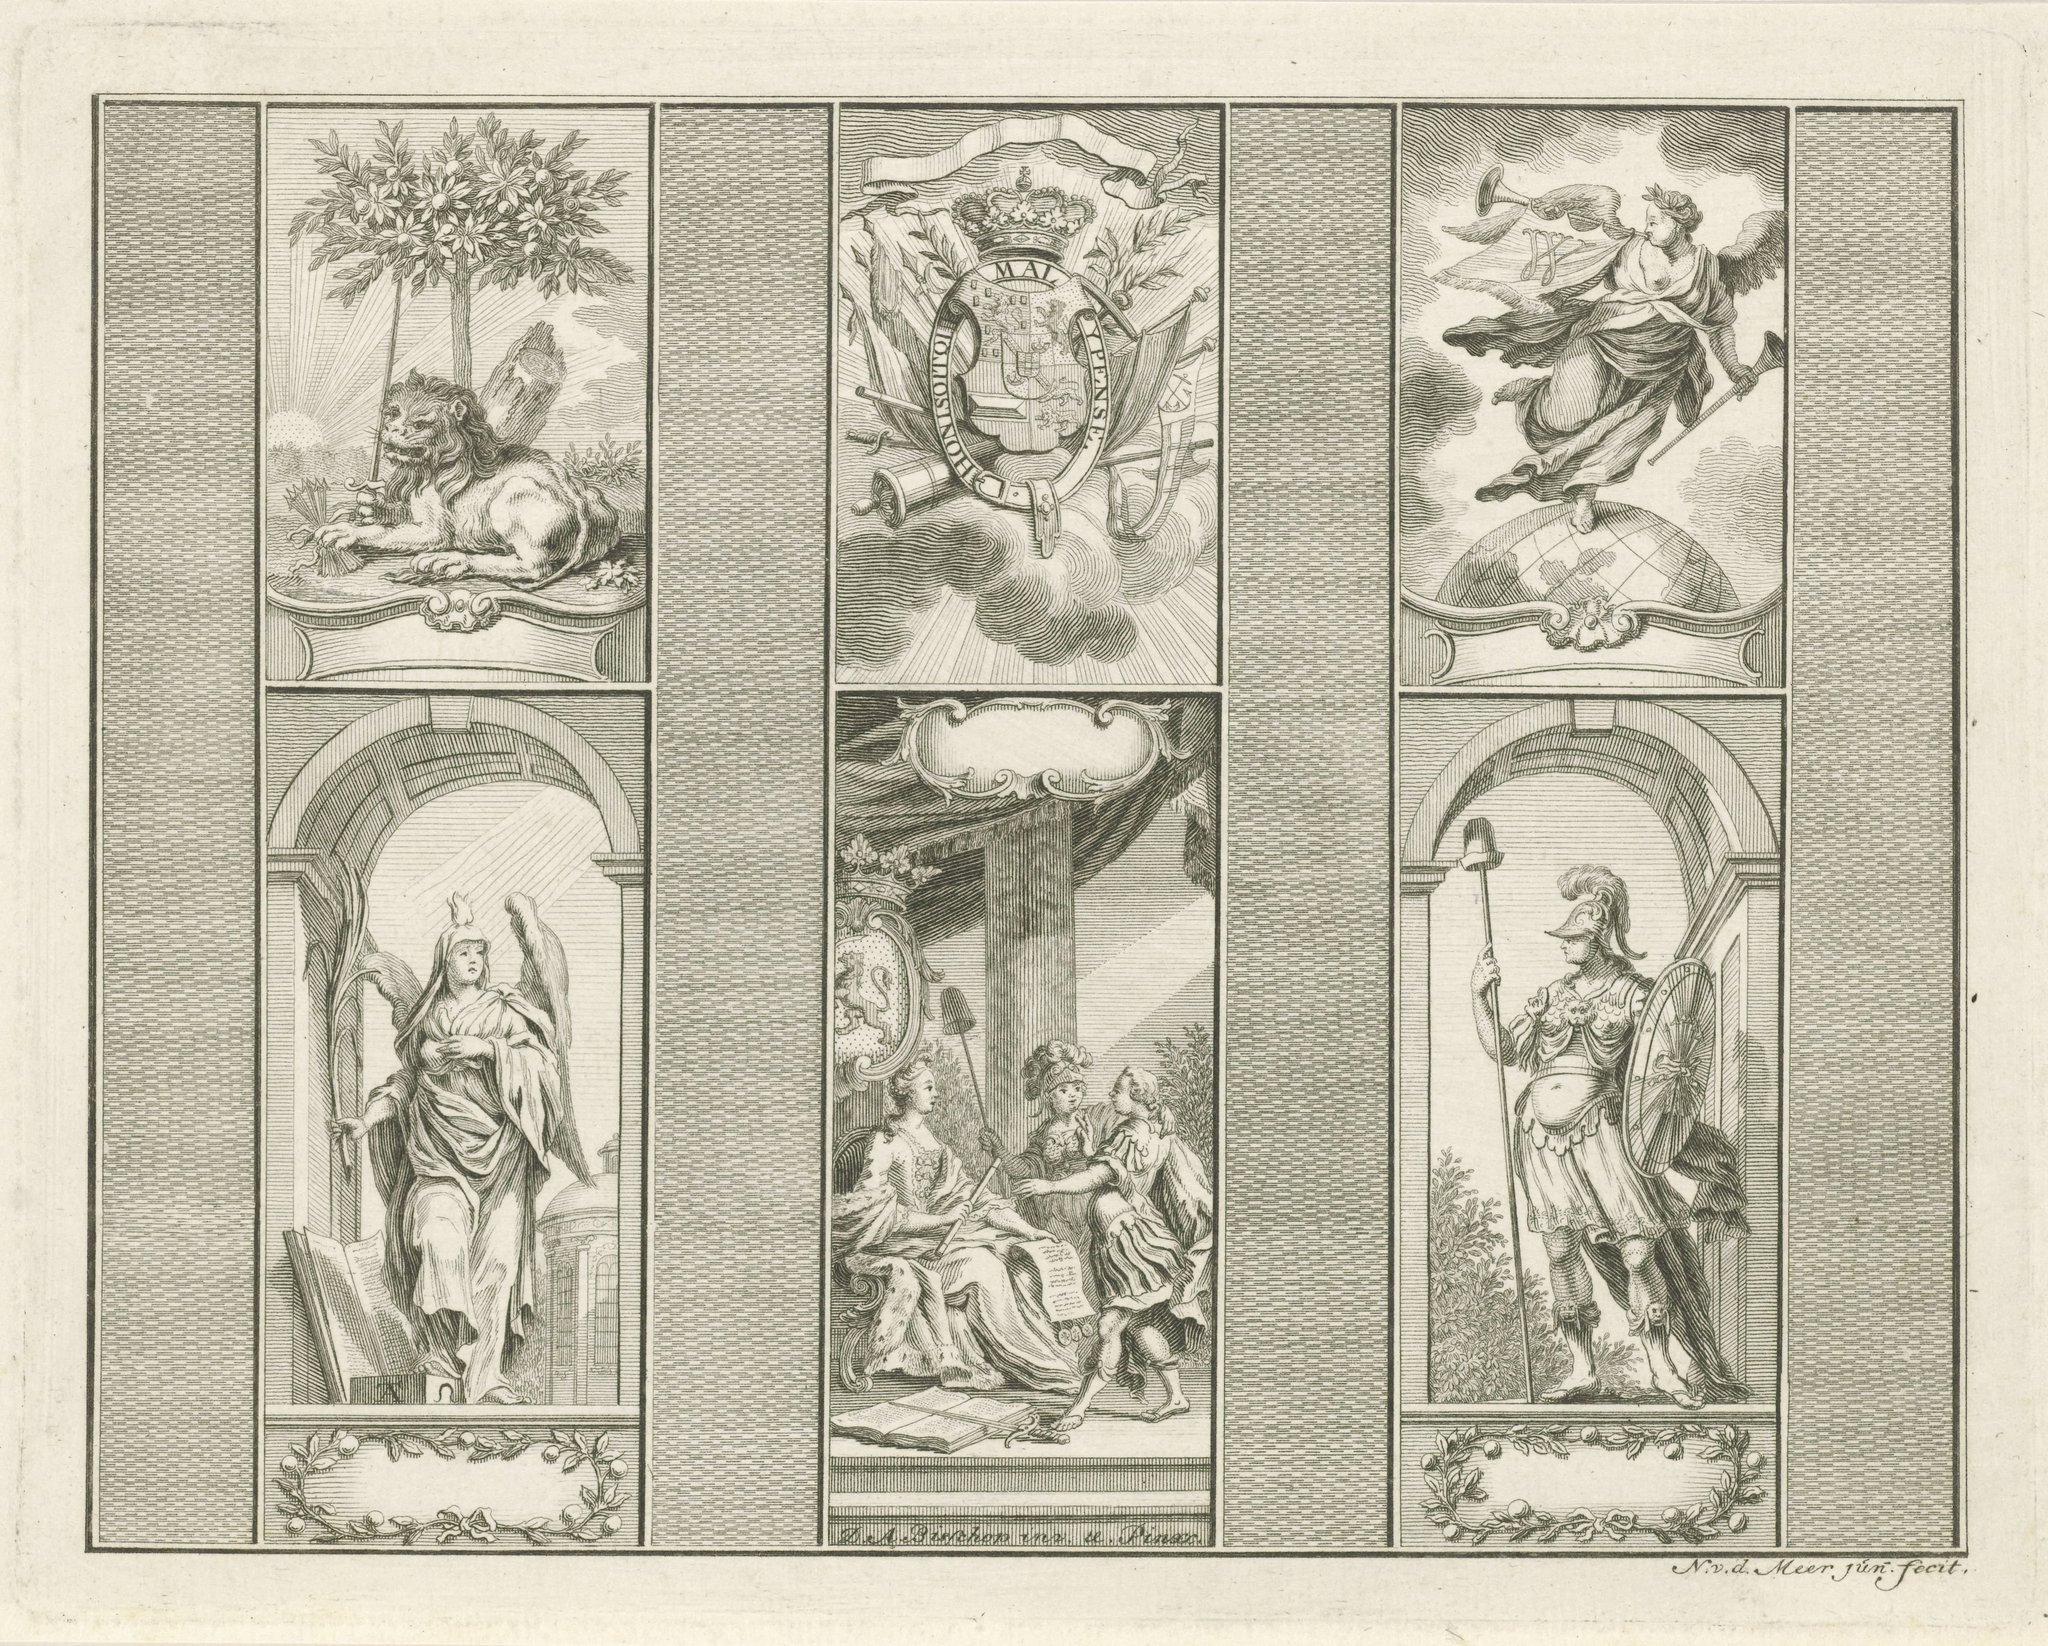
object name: print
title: Decoraties bij het huis van de heer Bisschop te Rotterdam, 1766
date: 1776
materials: paper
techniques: etching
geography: amsterdam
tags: william v (prince of orange), faith, 'fides'; 'fede', 'fede catholica', 'fede christiana', 'fede christiana catholica' (ripa) ~ one of the three theological virtues, strength, power; 'fortezza', 'fortezza d'animo e di corpo', 'fortezza del corpo congiunta con la generosità dell'animo', 'fortezza & valore del corpo congiunto con la prudenza & virtù del animo', 'forza' (ripa), swearing an oath (with two fingers raised), repute, renown; 'splendore del nome' (ripa)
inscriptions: collector's mark: Lugt 2228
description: Decoraties aangebracht bij het huis van de heer Dirk Anthony Bisschop te Rotterdam. Zes panelen met allegorische voorstellingen en emblemen. Linksboven de Hollandse Leeuw met de pijlenbundel en het zwaard, midden boven het wapenschild van Willem V. Rechtsboven de Faam met een banier met de letter W. Linksonder de personificatie van het Geloof en rechtonder de Kracht. Midden onder de Hollandse Maagd op een troon en Willem V, die een gelofte aflegd. Ter gelegenheid van de meerderjarigheid van prins Willem V op 8 maart 1766.